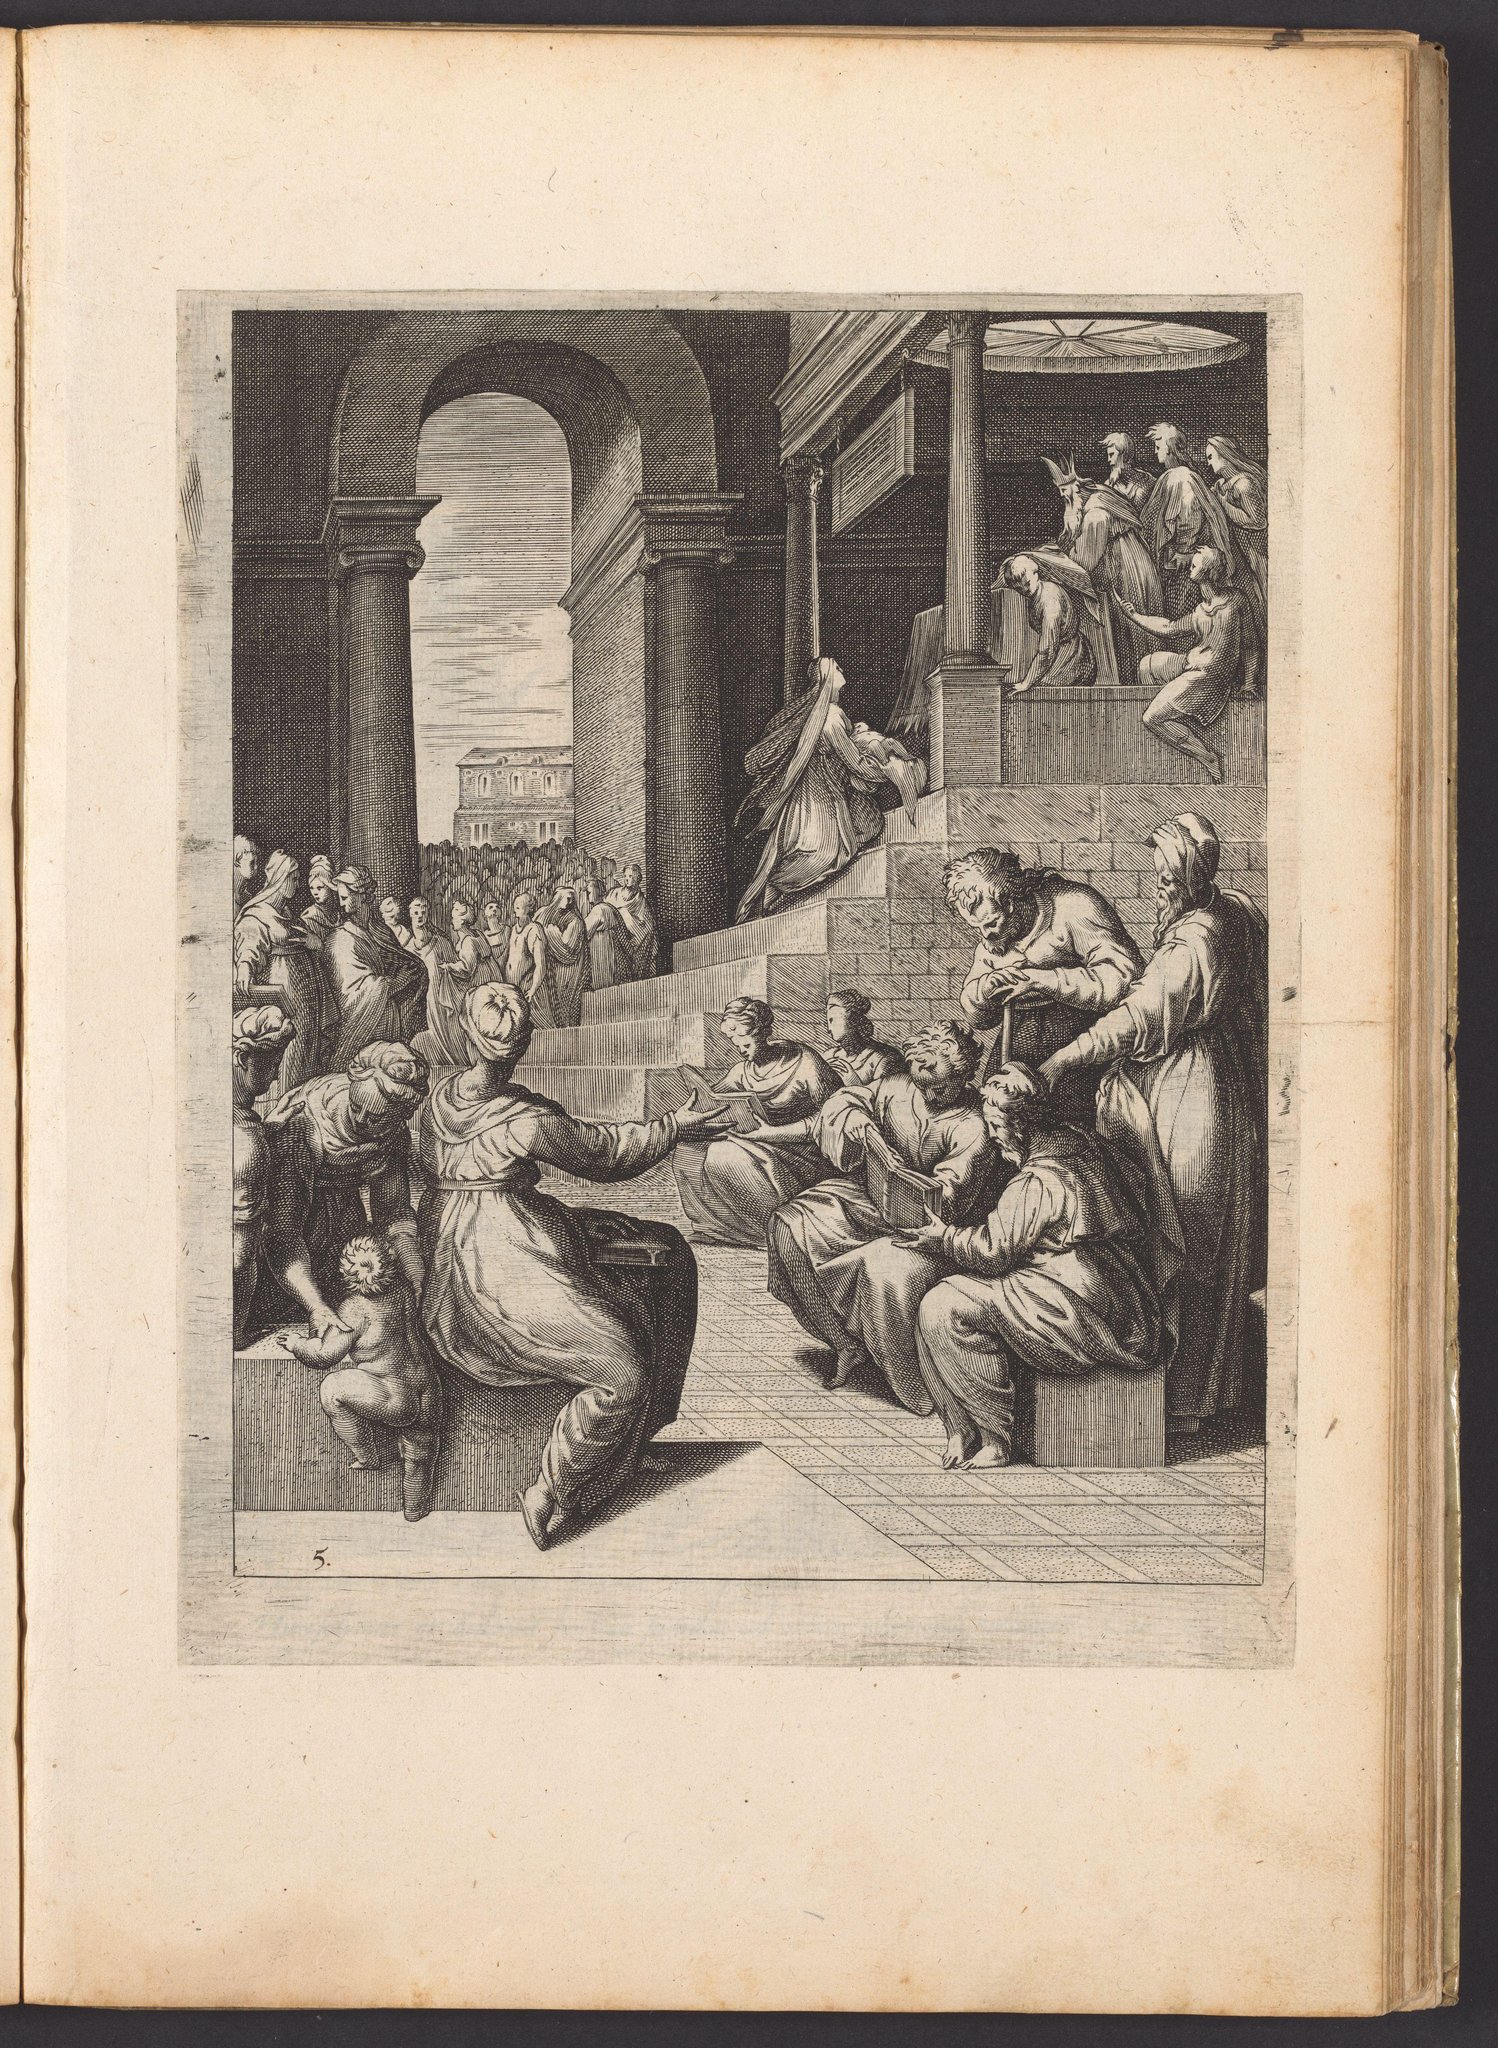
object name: album leaf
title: Presentatie in de tempel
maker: isaac duchemin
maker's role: draughtsman, print maker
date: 1573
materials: paper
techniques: engraving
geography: brussels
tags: presentation of the christ-child in the temple, usually simeon (and anna) present (luke 2:22-39)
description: Deze prent maakt deel uit van een album.